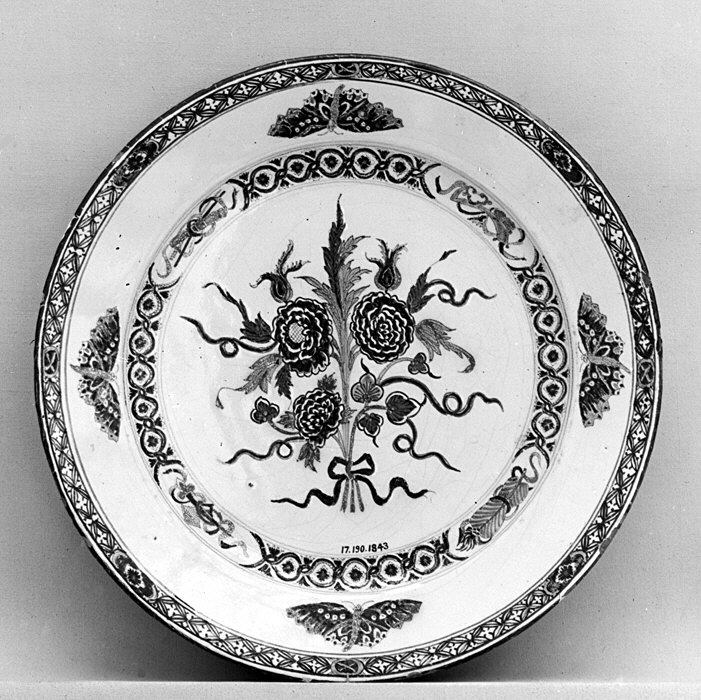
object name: plate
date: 1751-1775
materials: faience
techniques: glazing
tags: butterflies,flowers